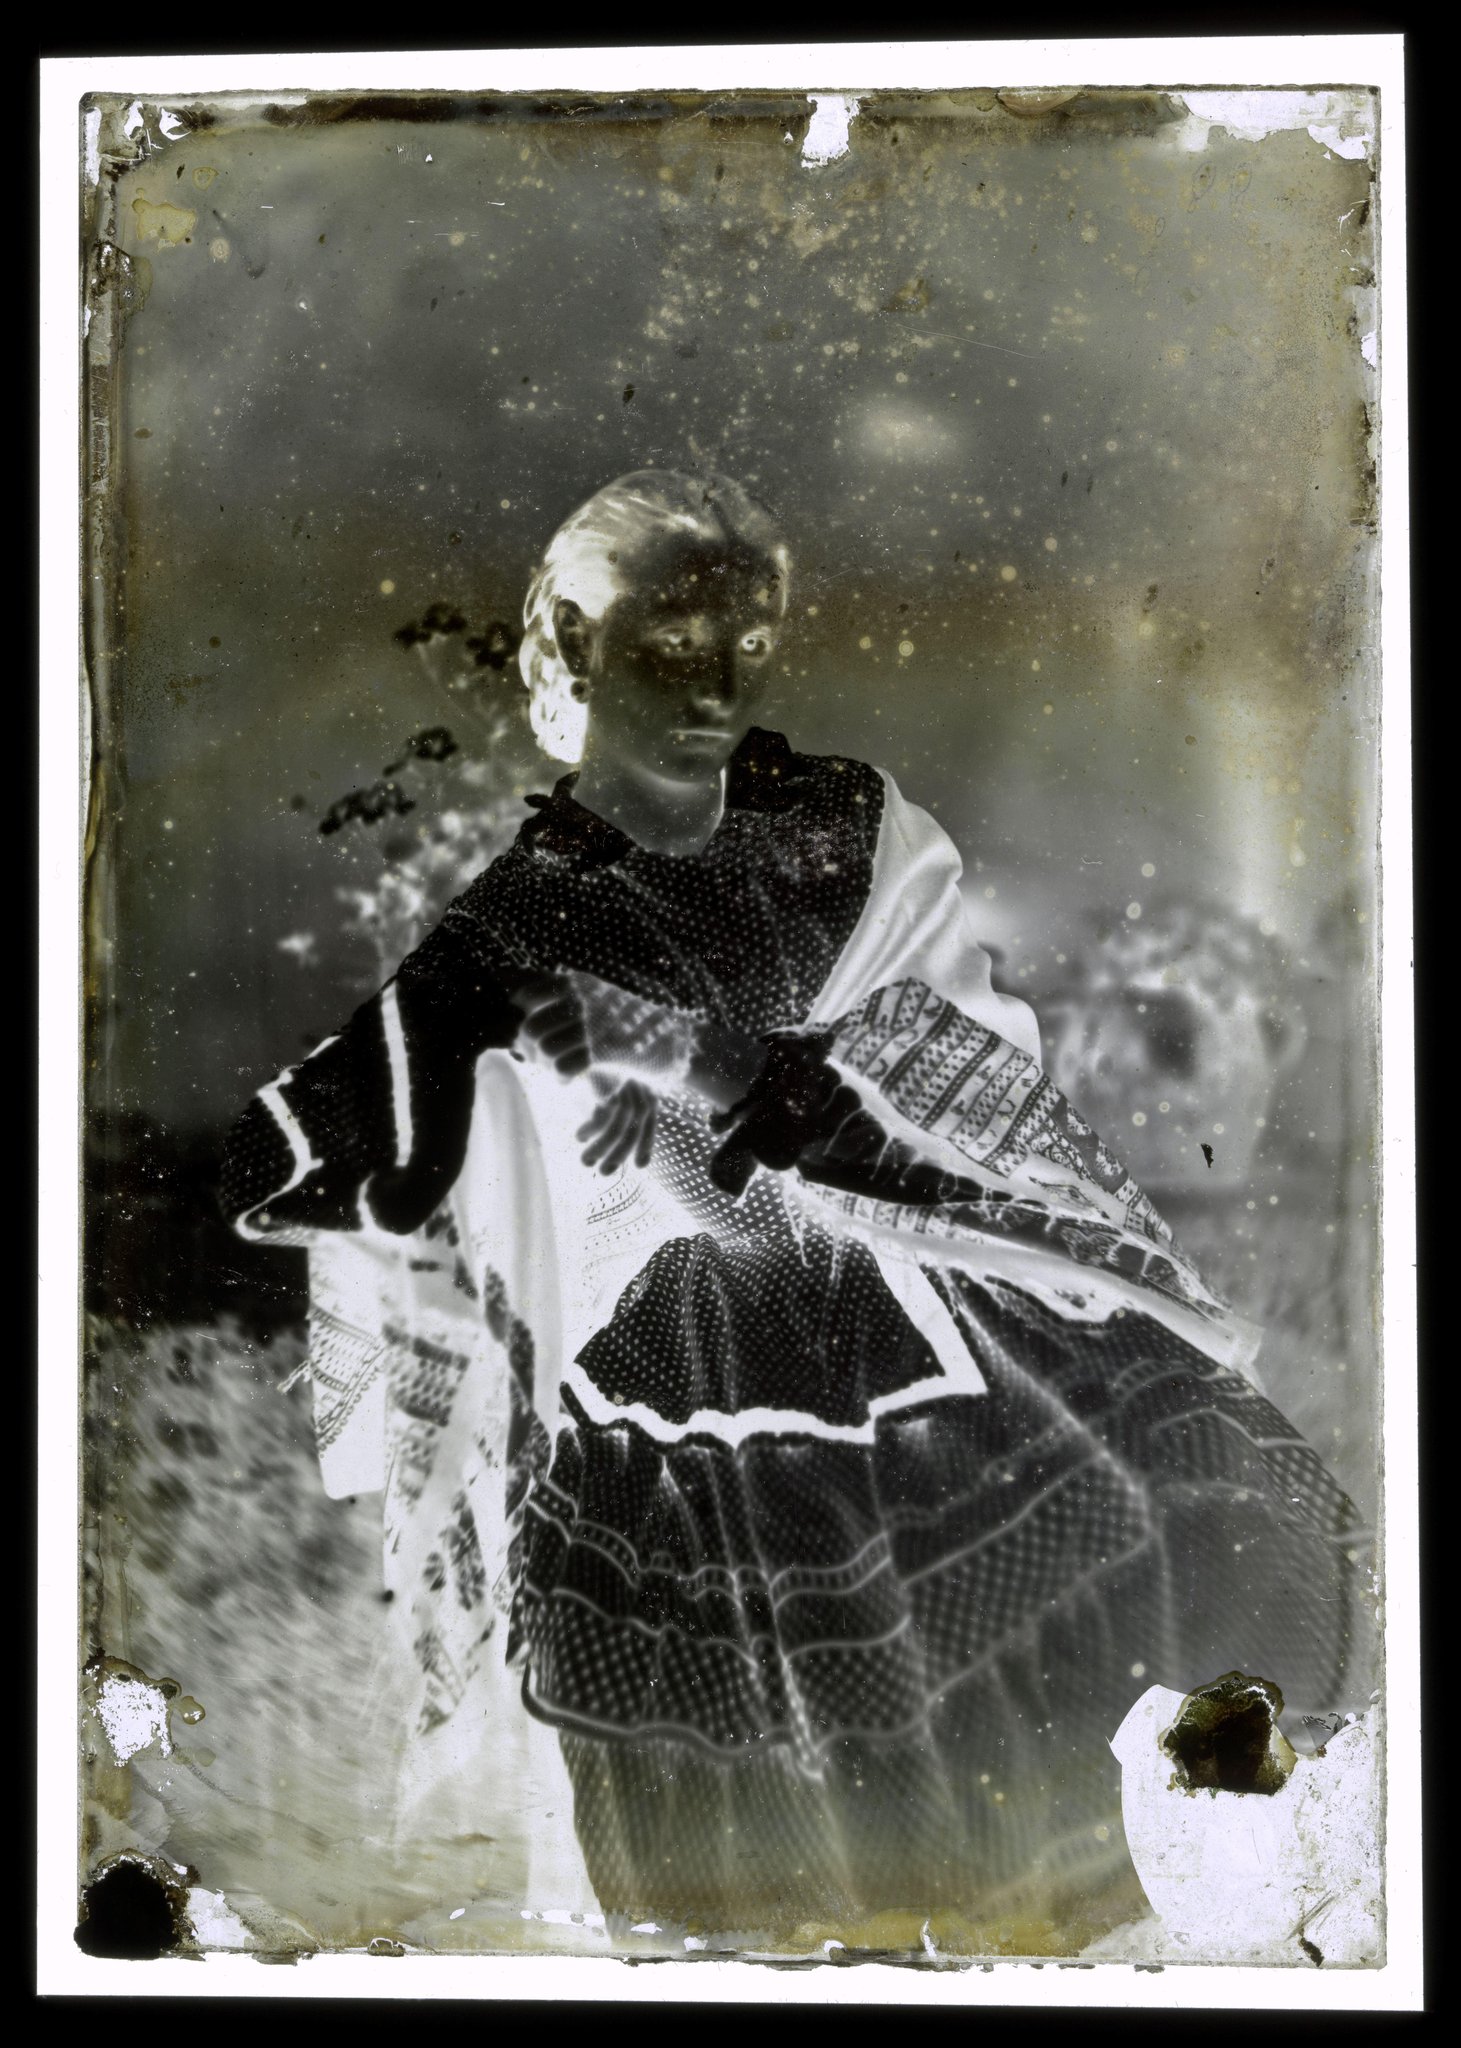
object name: glasnegatief, glasplaatnegatief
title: Portret van een onbekende jonge vrouw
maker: laurens lodewijk kleijn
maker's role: draughtsman, painter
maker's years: 1826-1909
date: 1865-1900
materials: glass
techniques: collodion process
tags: anonymous historical person portrayed - bb - woman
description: Onderdeel van een groep glasnegatieven uit de nalatenschap van de schilder Laurens Lodewijk Kleijn, met stillevens, portretten, zelfportretten en kunstreproducties.